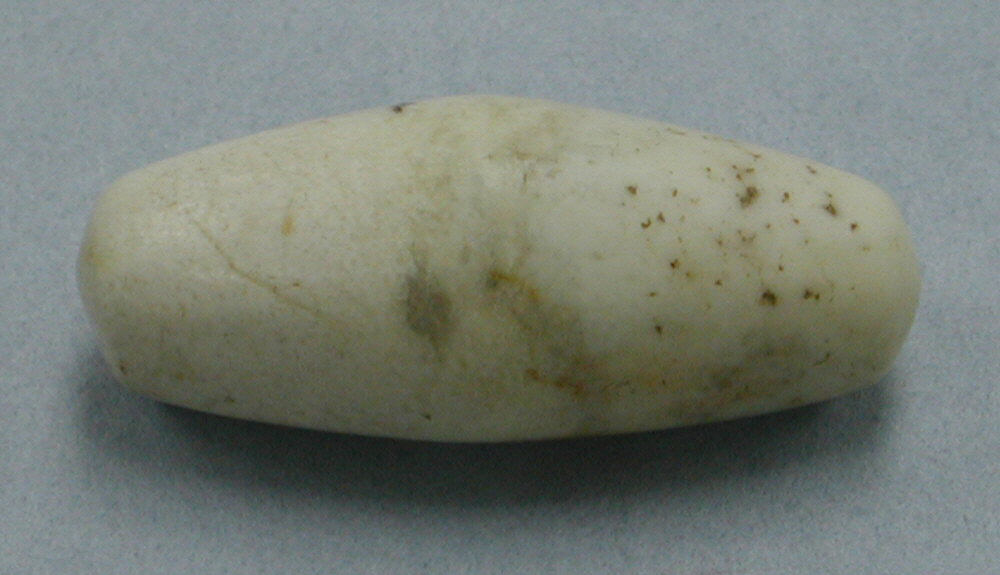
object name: ritual stone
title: Stone Pulidor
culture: mexican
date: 1501-1600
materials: stone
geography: mexico